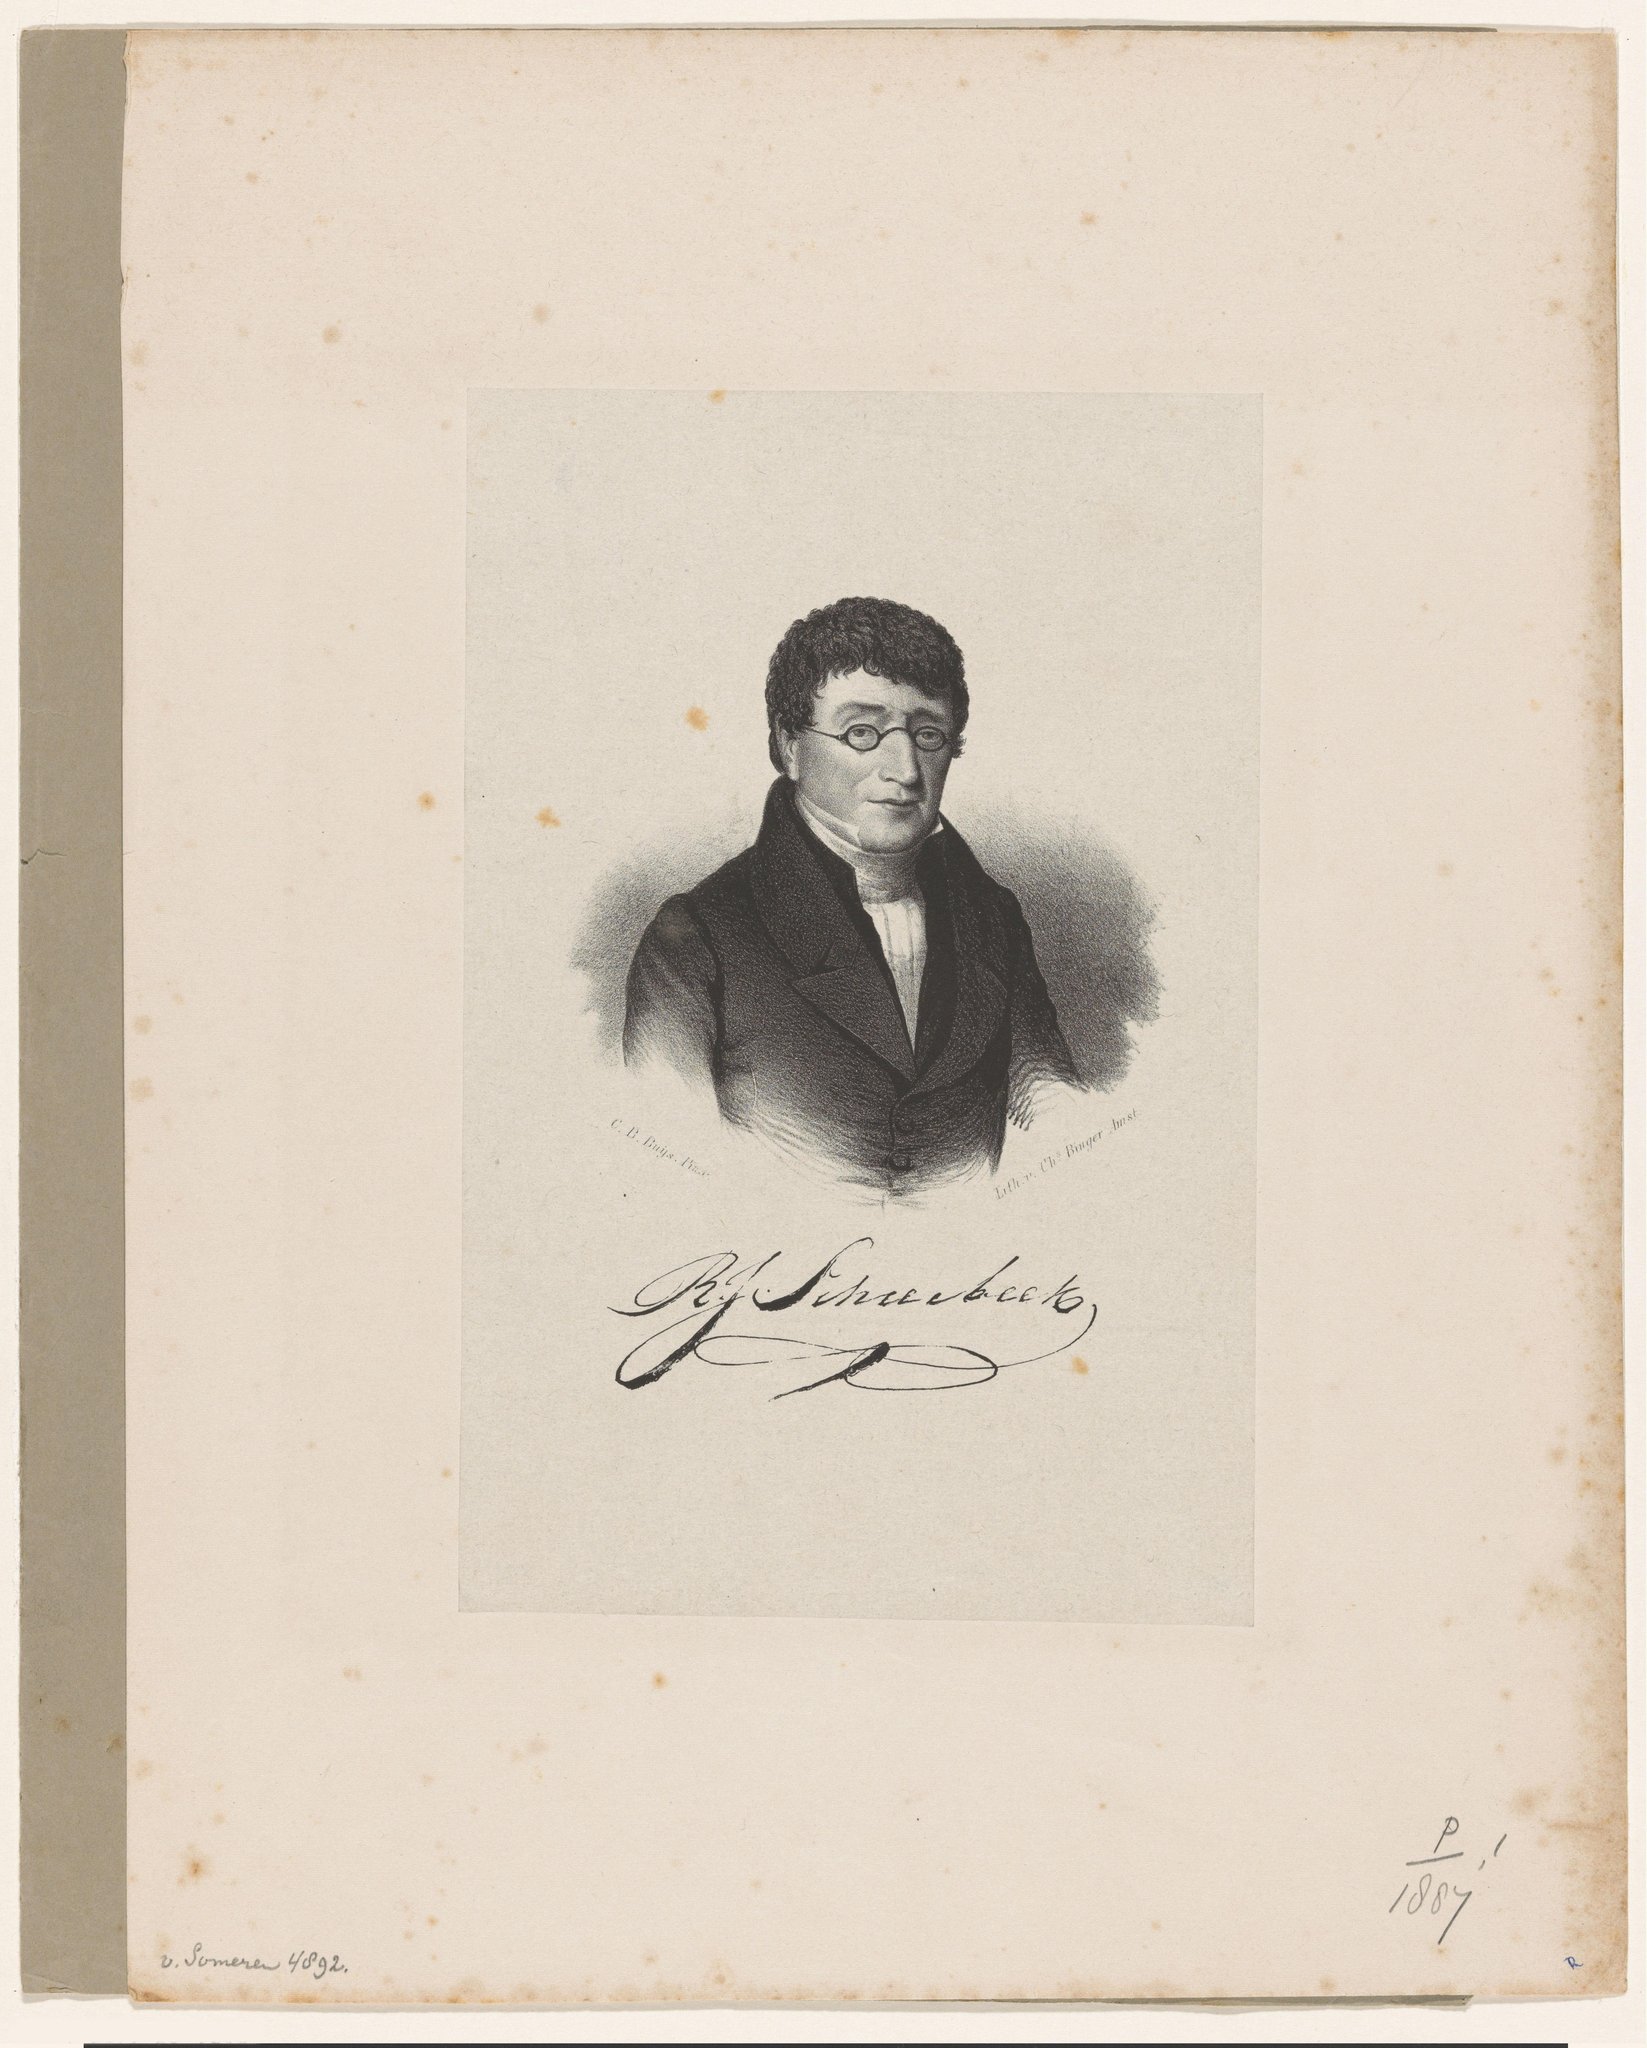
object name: print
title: Portret van Roelof Jacob Schierbeek, boekhandelaar en uitgever te Groningen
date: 1856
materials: paper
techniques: lithograph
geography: amsterdam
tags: publisher, roelof jacob schierbeek, eyeglasses, spectacles, publishing, publisher, book-shop, bookseller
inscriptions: collector's mark: Lugt 4780, collector's mark: Lugt 2228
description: Volgens Van Someren is de prent ook gebruikt in: Adresboek voor den Nederlandschen boekhandel, 1856. Bij de prent wordt een tekstvel met een levensbeschrijving van de voorgestelde bewaard.